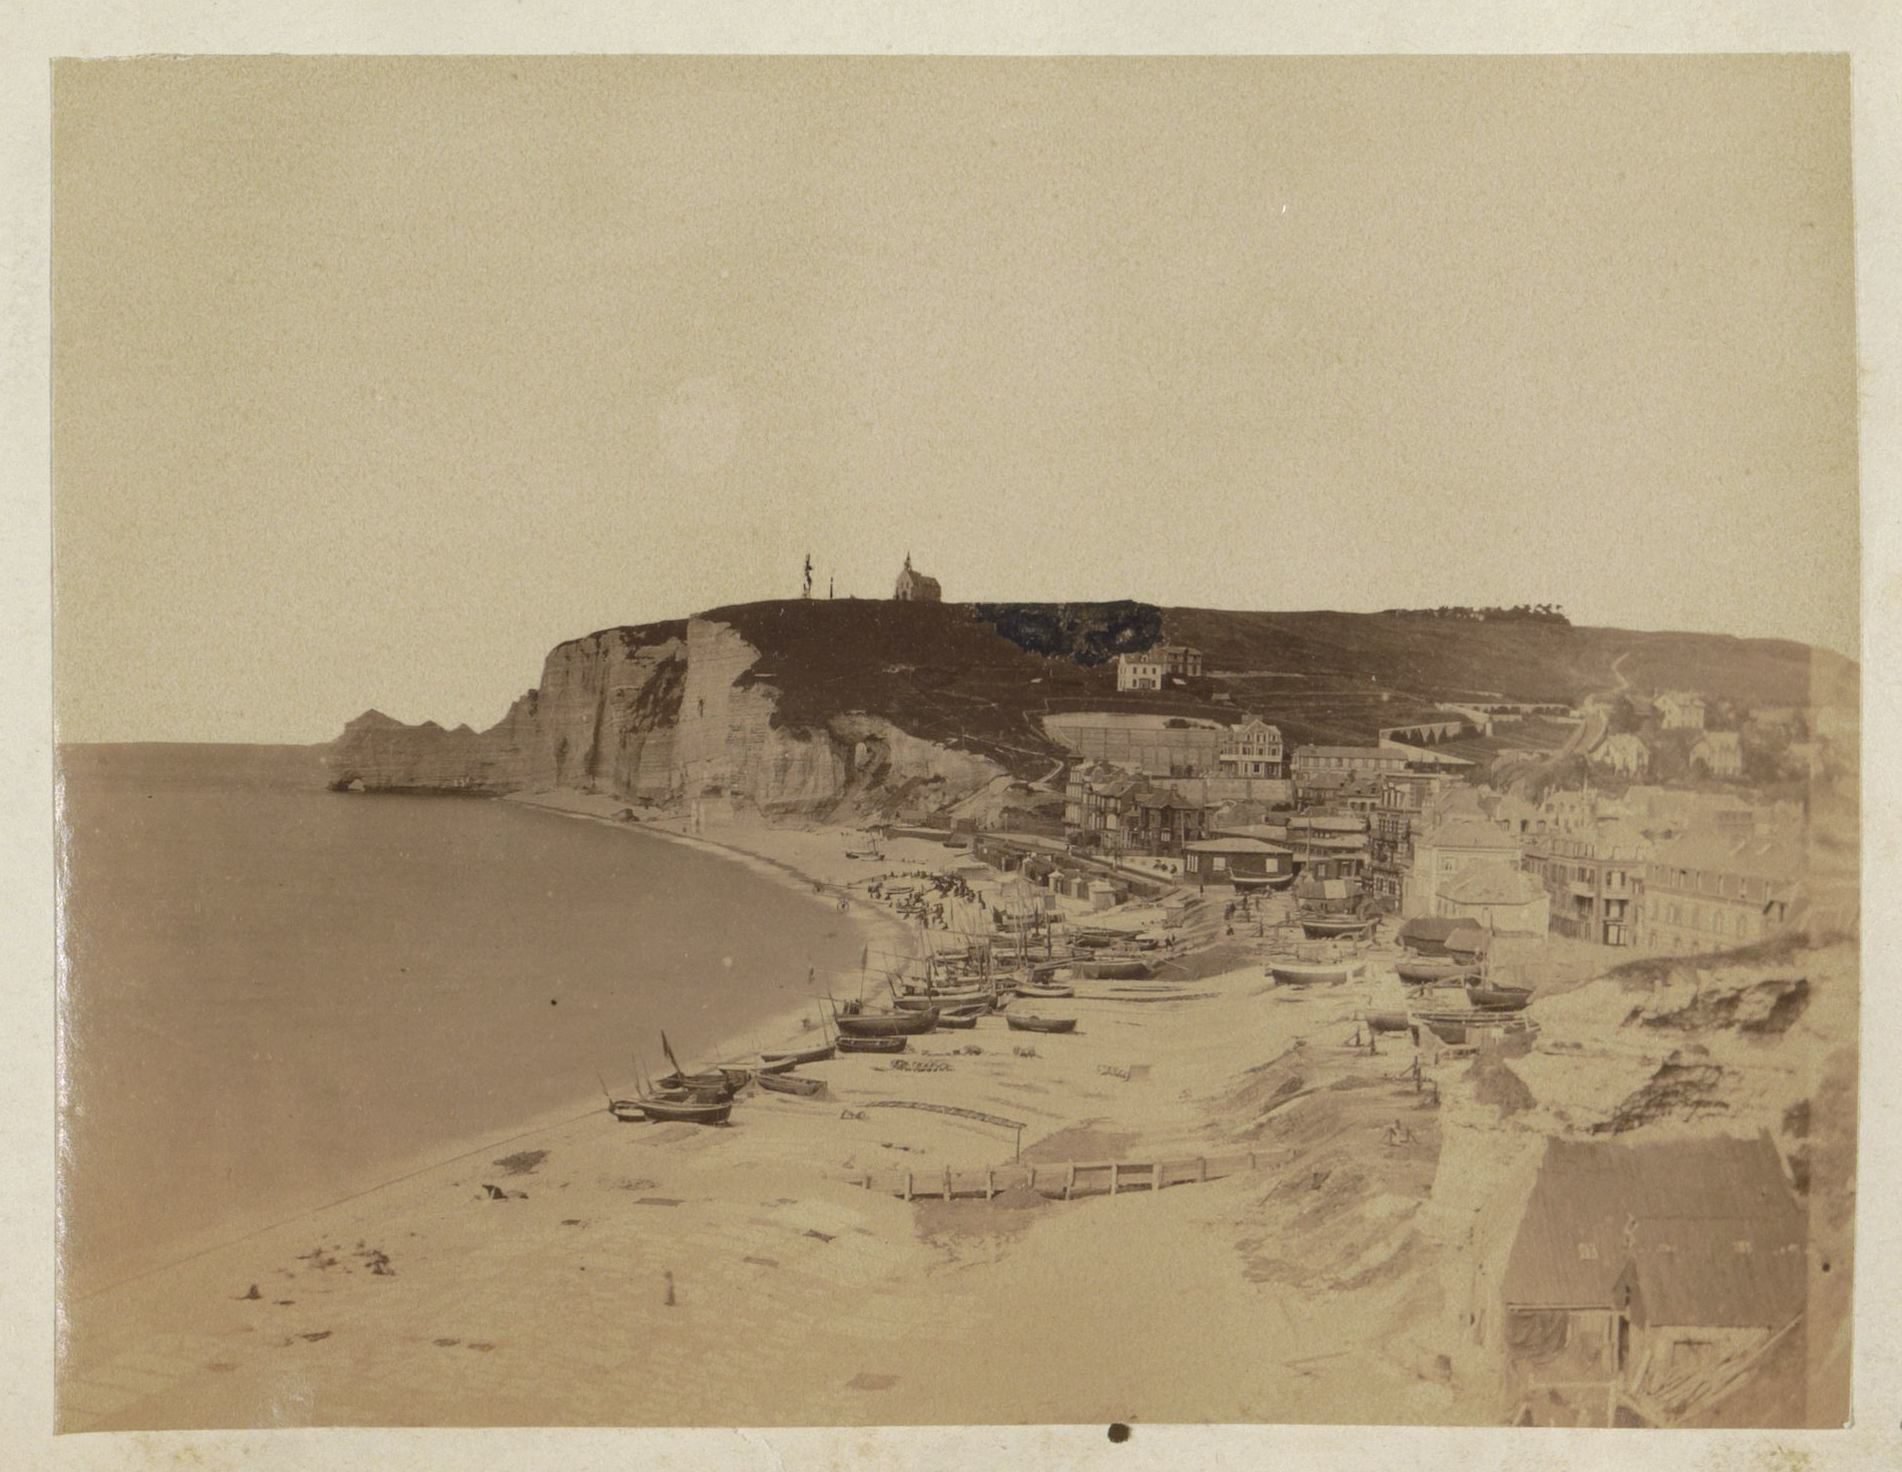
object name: photograph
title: Gezicht op Etretat vanuit het zuiden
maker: Anonymous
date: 1808-1883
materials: photographic support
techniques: albumen print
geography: etretat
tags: coast, coastal cliff or crag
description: Onderdeel van Album van een Franse amateurfotograaf met opnames van familie, militairen, industrie, landschappen en bezienswaardigheden in Frankrijk.